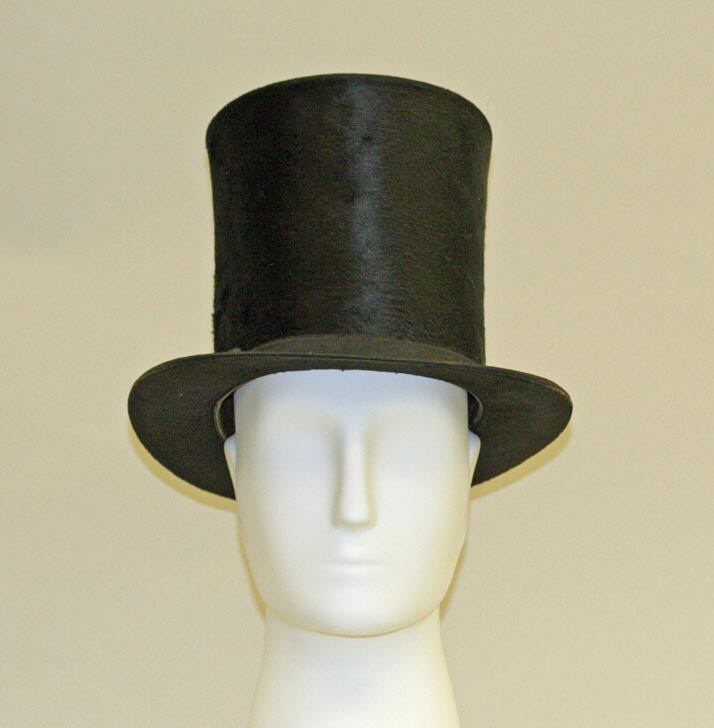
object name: top hat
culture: american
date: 1851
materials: silk